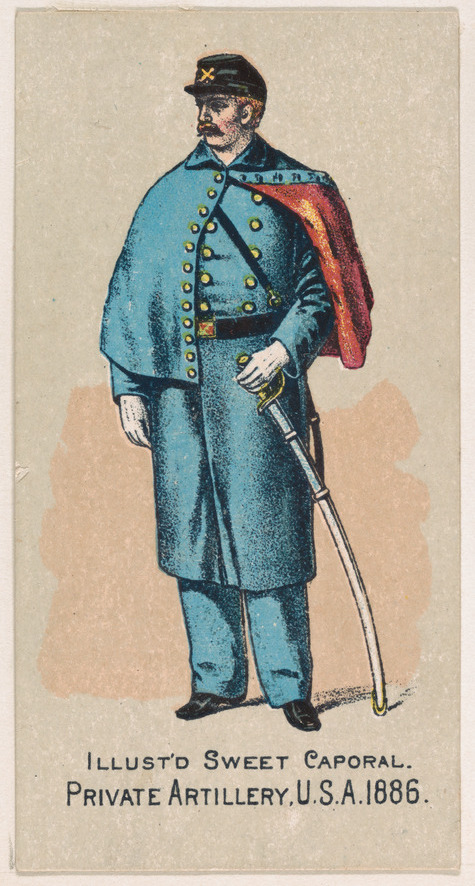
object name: print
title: Private Artillery, United States Army, 1886, from the Military Series (N224) issued by Kinney Tobacco Company to promote Sweet Caporal Cigarettes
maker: kinney brothers tobacco company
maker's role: publisher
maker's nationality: american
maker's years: 1869-2011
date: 1888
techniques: color lithograph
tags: military,men,profiles